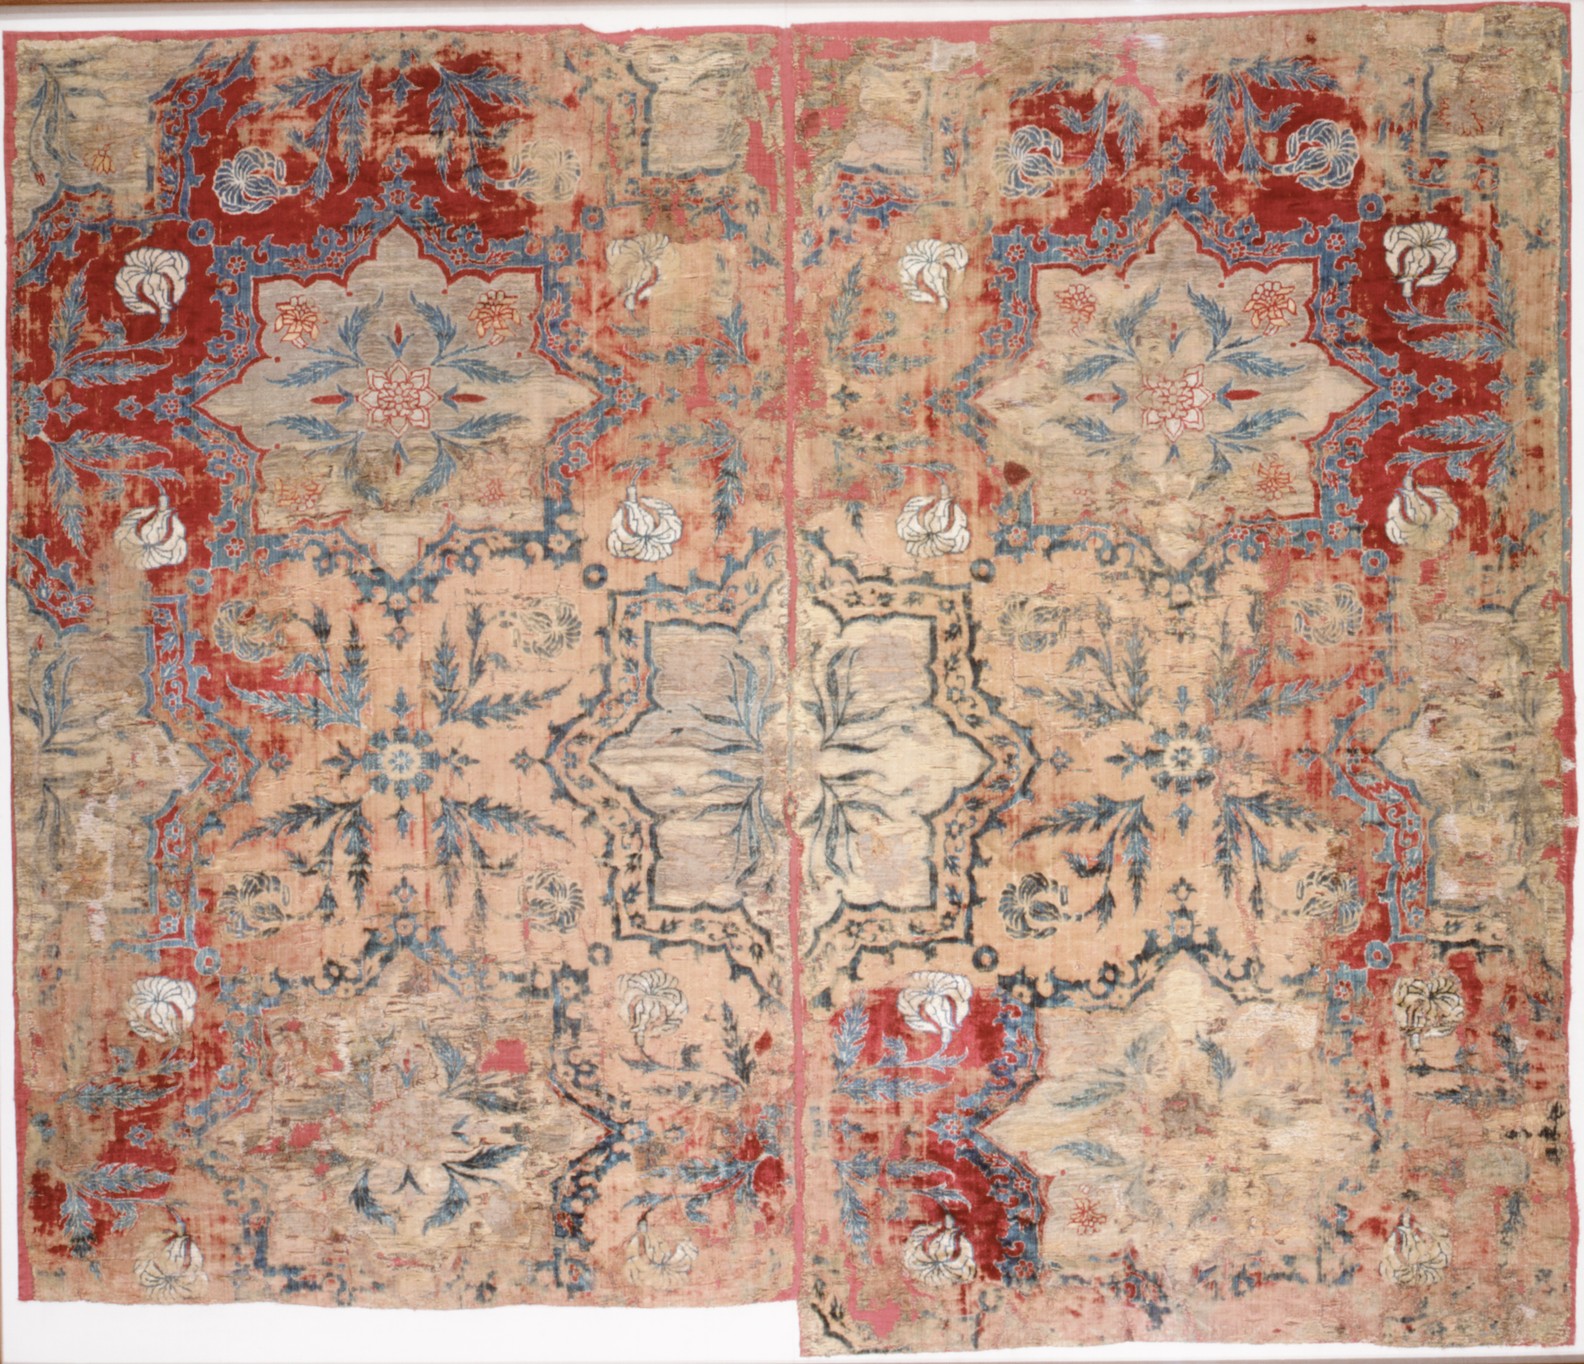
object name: textile fragment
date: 1634-1666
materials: metal, silk, velvet, thread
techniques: cutting, voiding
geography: india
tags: flowers